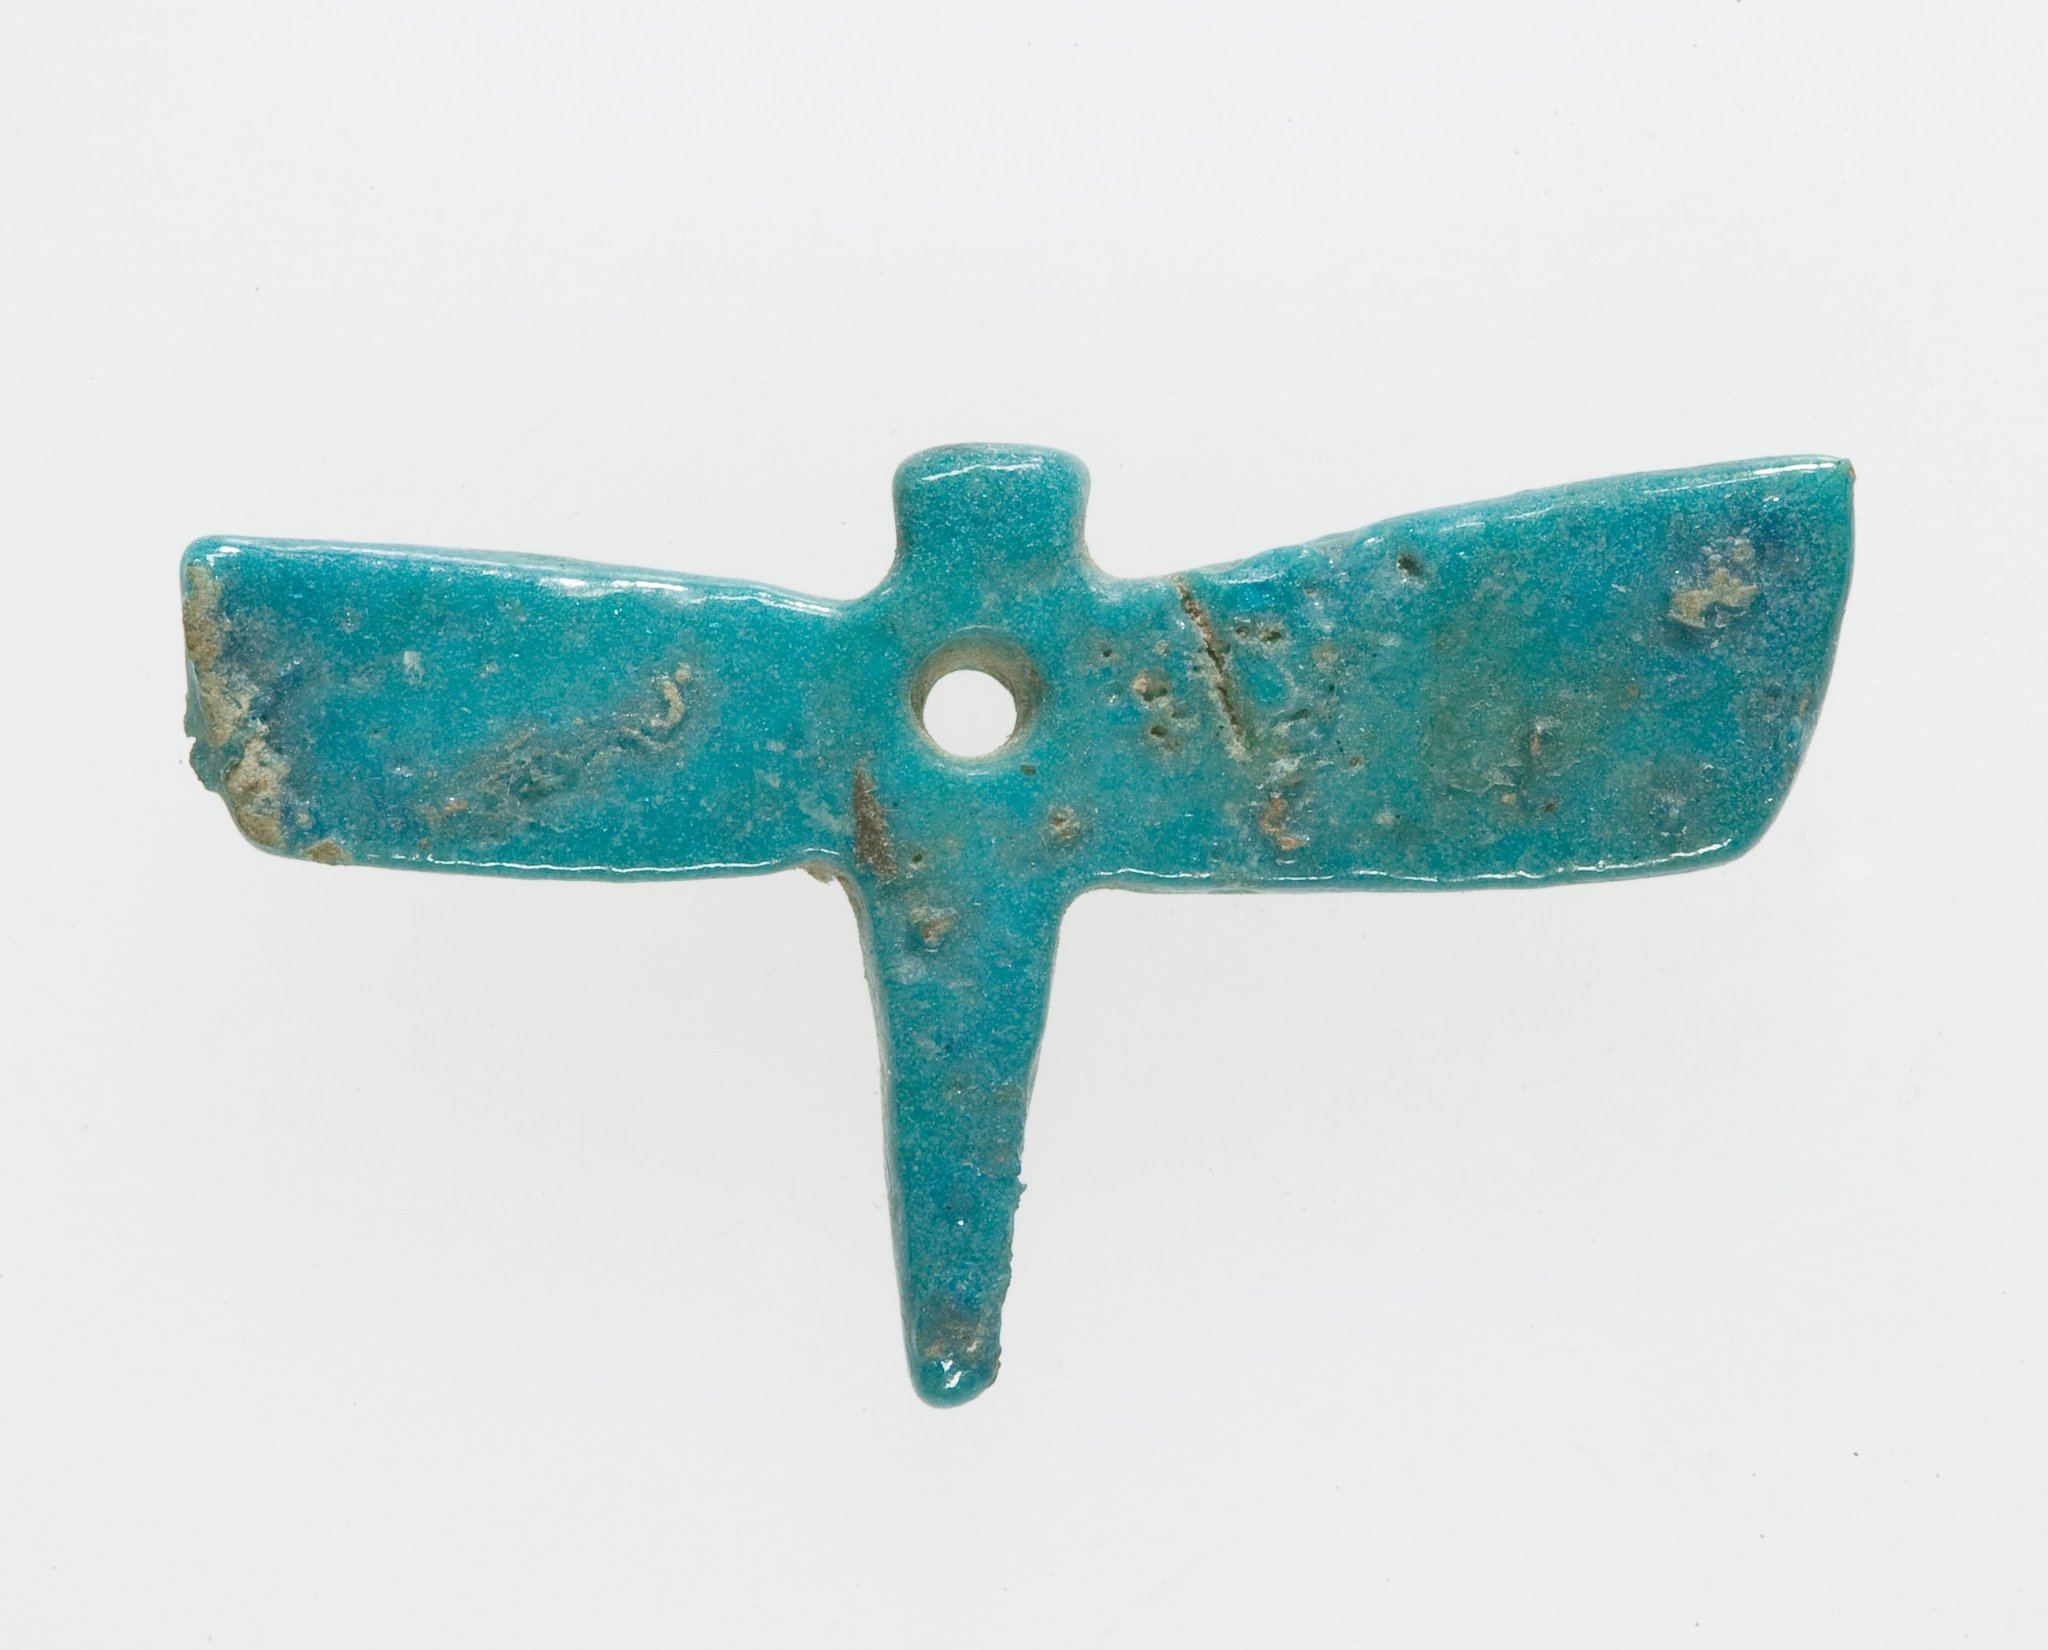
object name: amulet, dragonfly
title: Dragonfly amulet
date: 1981-1640 BCE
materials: faience, paint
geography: egypt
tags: dragonflies